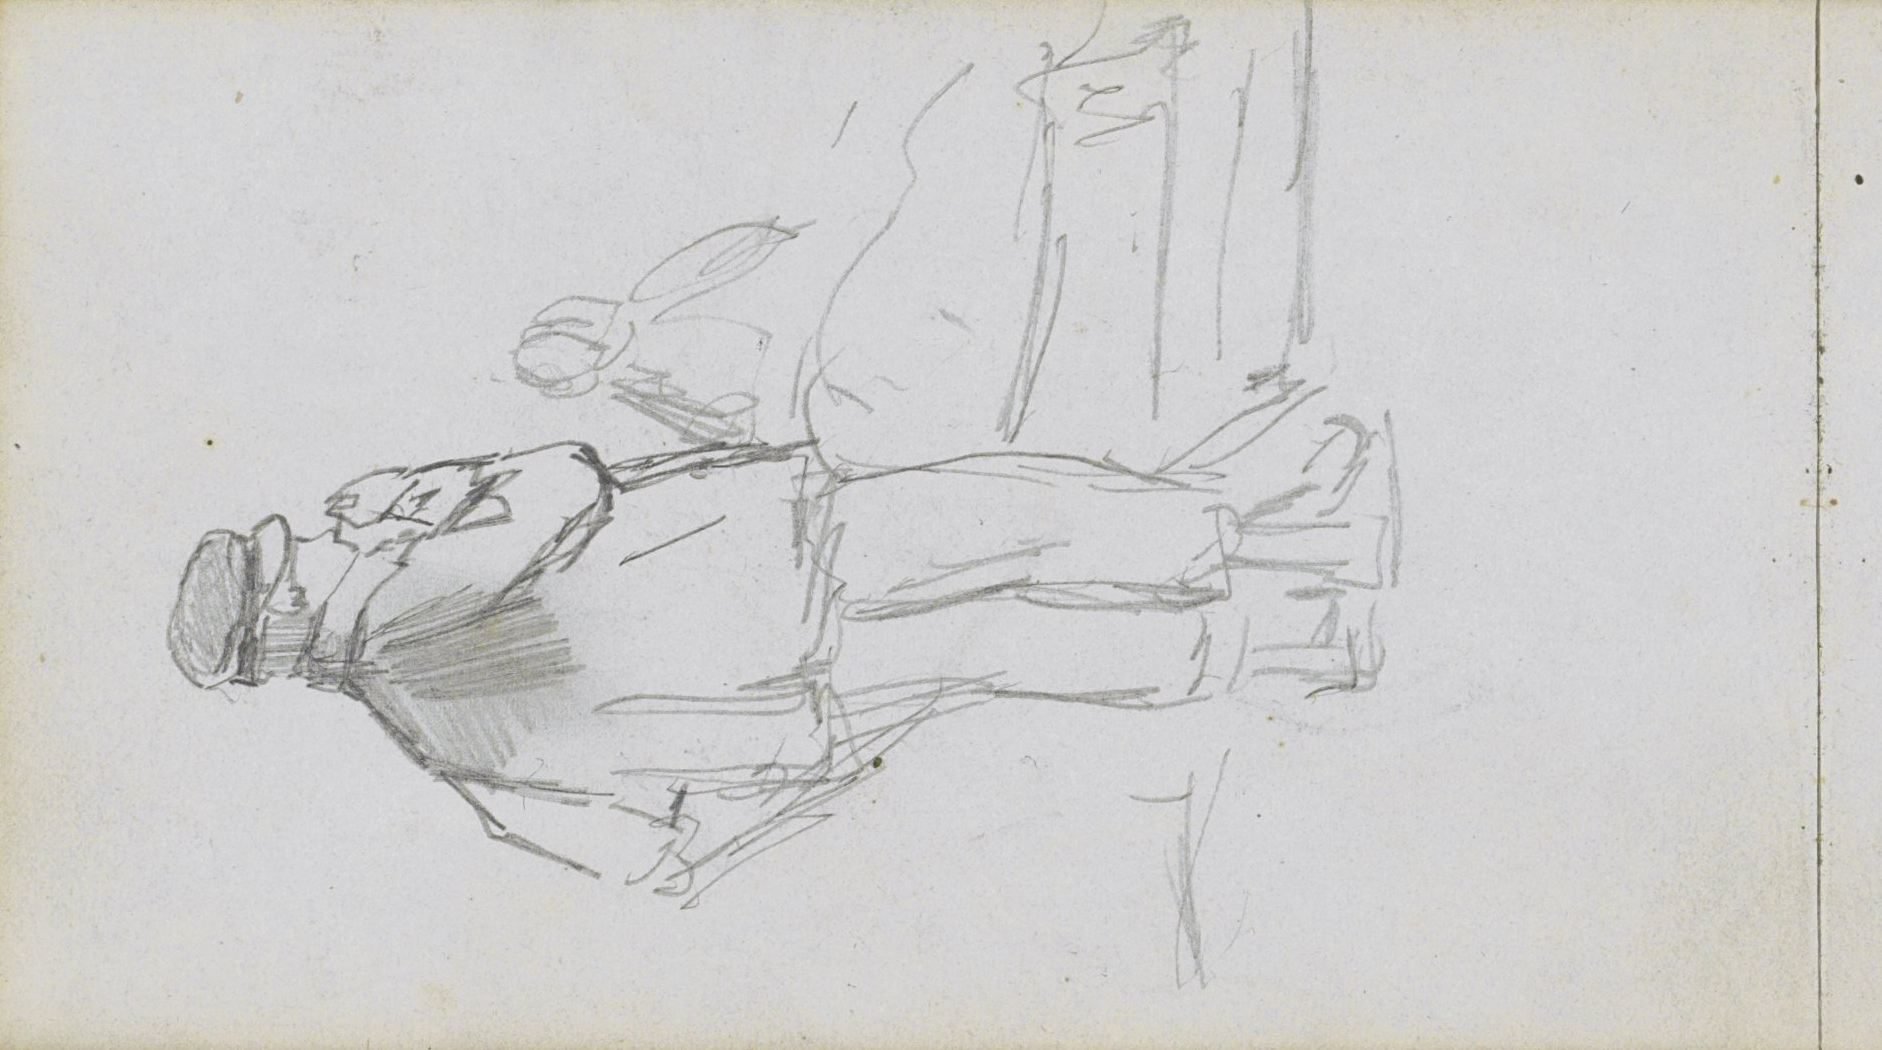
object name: sketchbook leaf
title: Staande man met een pet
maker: johan hendrik weissenbruch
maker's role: draughtsman, painter, print maker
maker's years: 1824-1903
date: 1834-1903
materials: paper, pencil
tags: standing figure (+ adult male (human being)), head-gear: hat (+ men's clothes)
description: Blad 14 verso uit een schetsboek met 39 bladen.